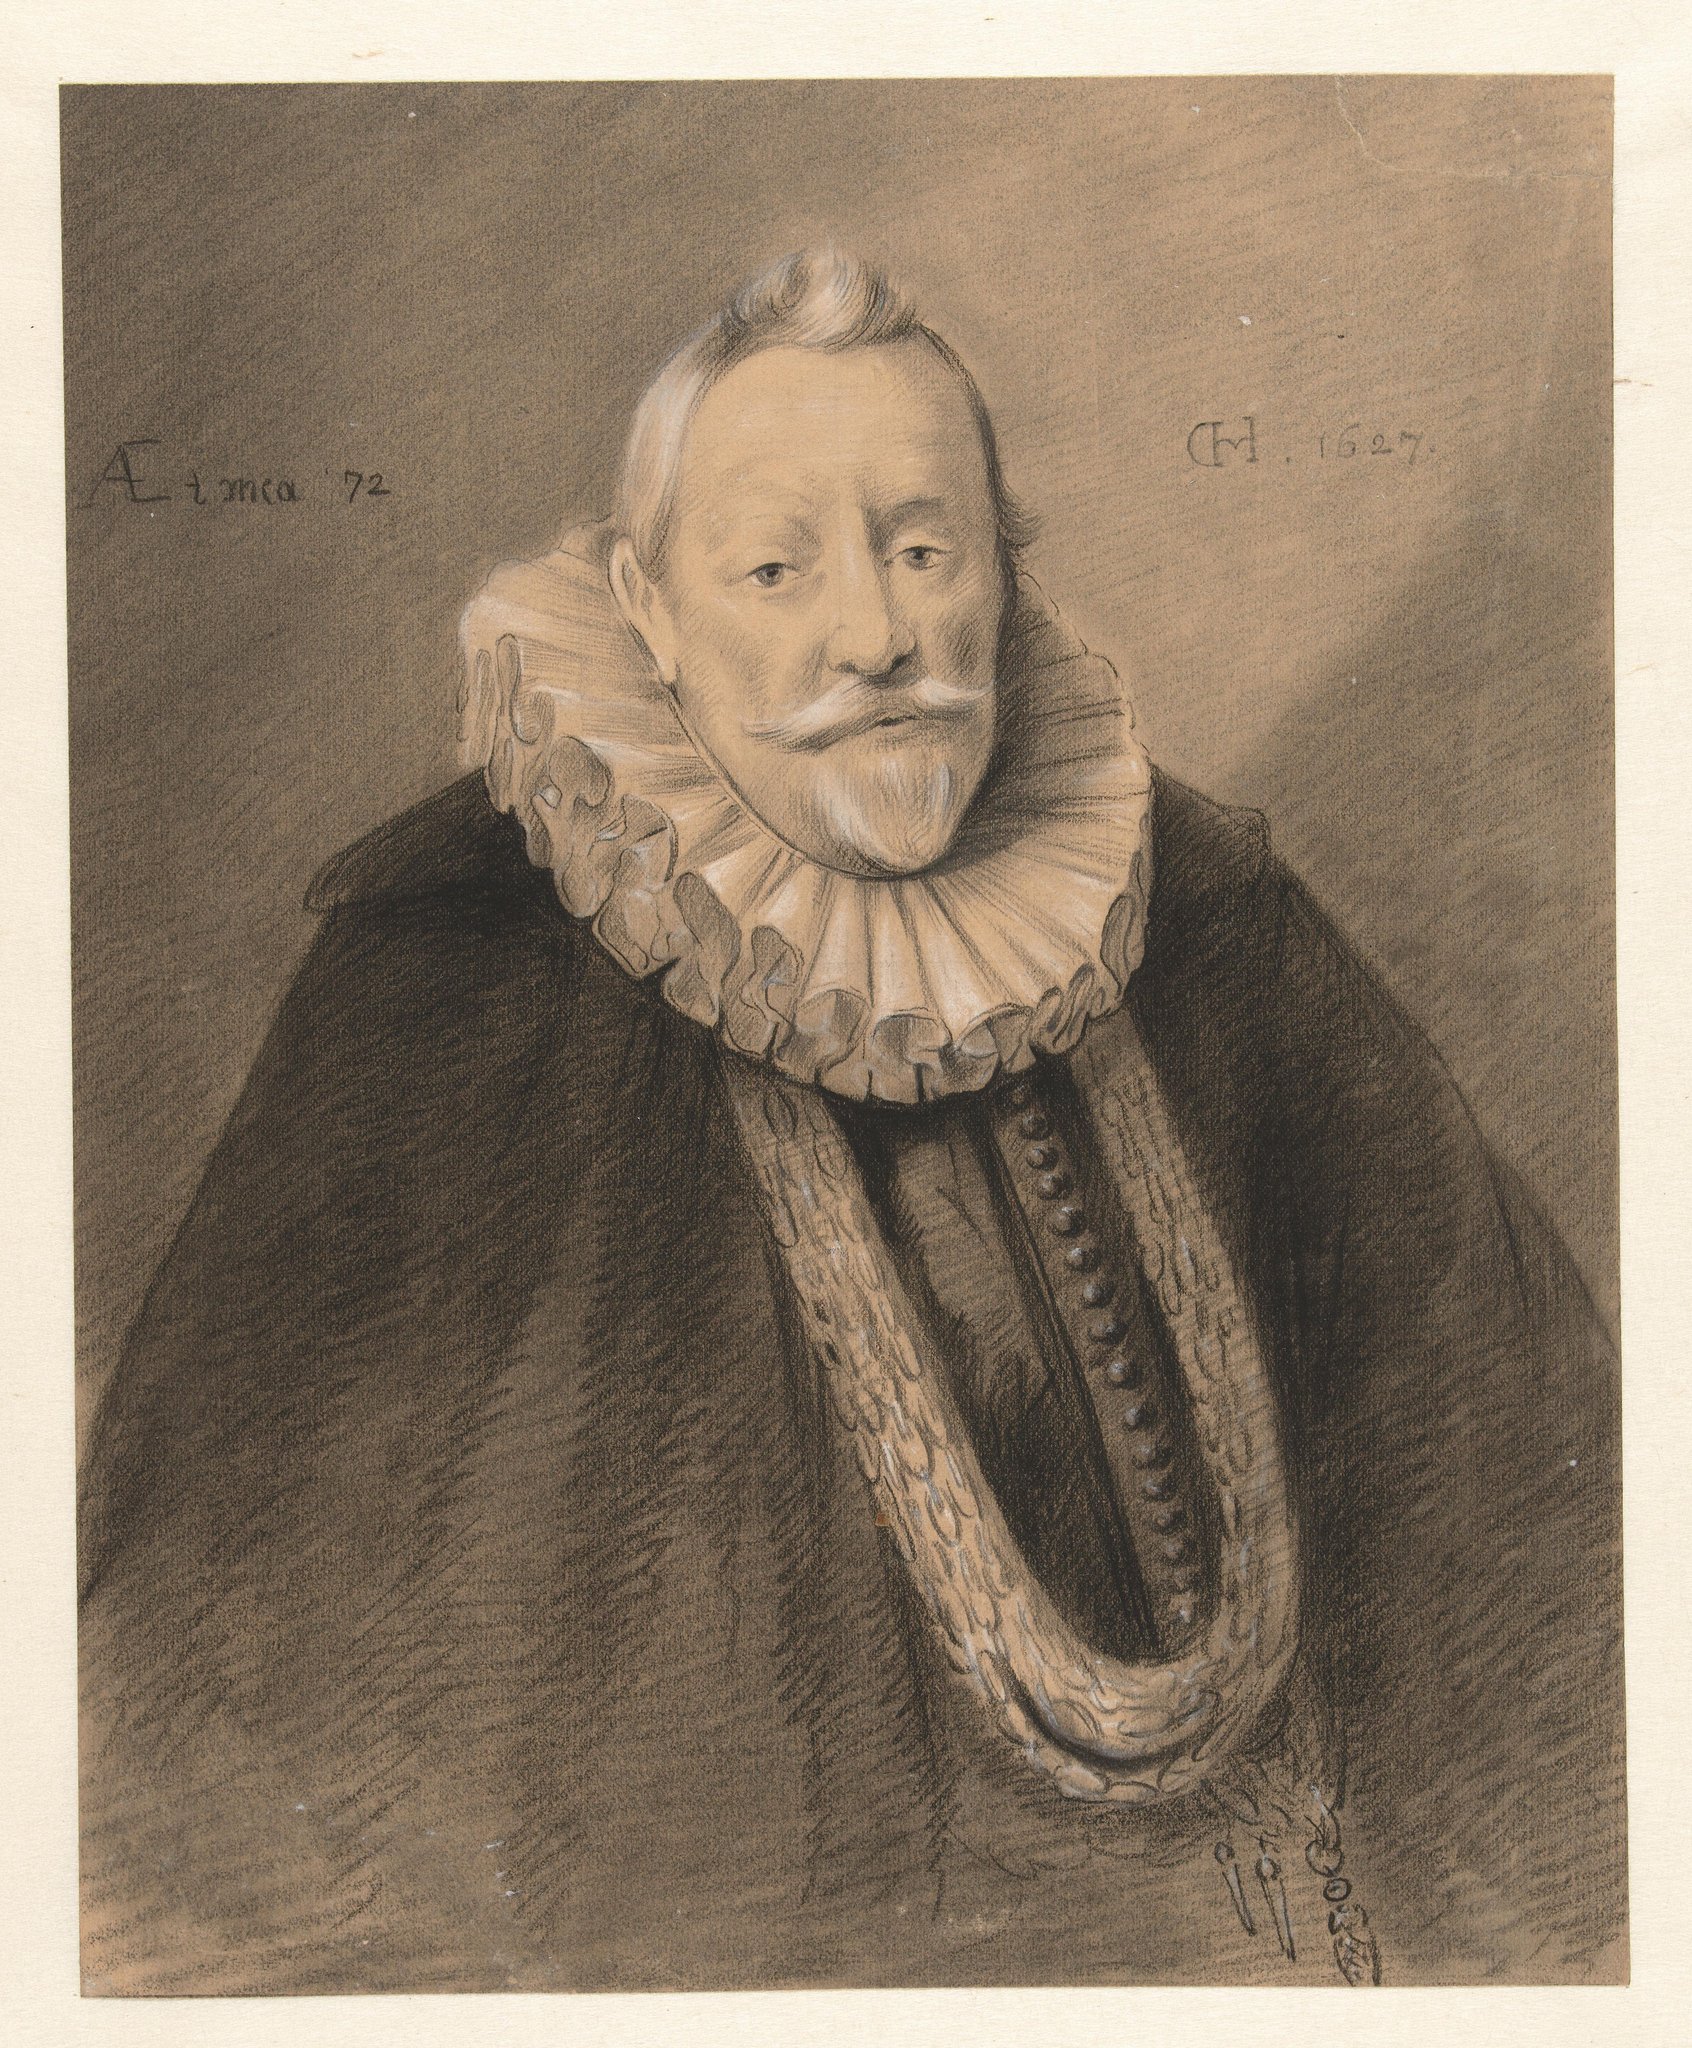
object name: drawing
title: Portret van Floris van Schagen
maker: bernardus gerardus ten berge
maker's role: draughtsman, print maker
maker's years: 1835-1875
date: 1845-1875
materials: chalk, paper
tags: historical persons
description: Portret van Floris van Schagen, kapitein onder Bossu, gouverneur van Holland.